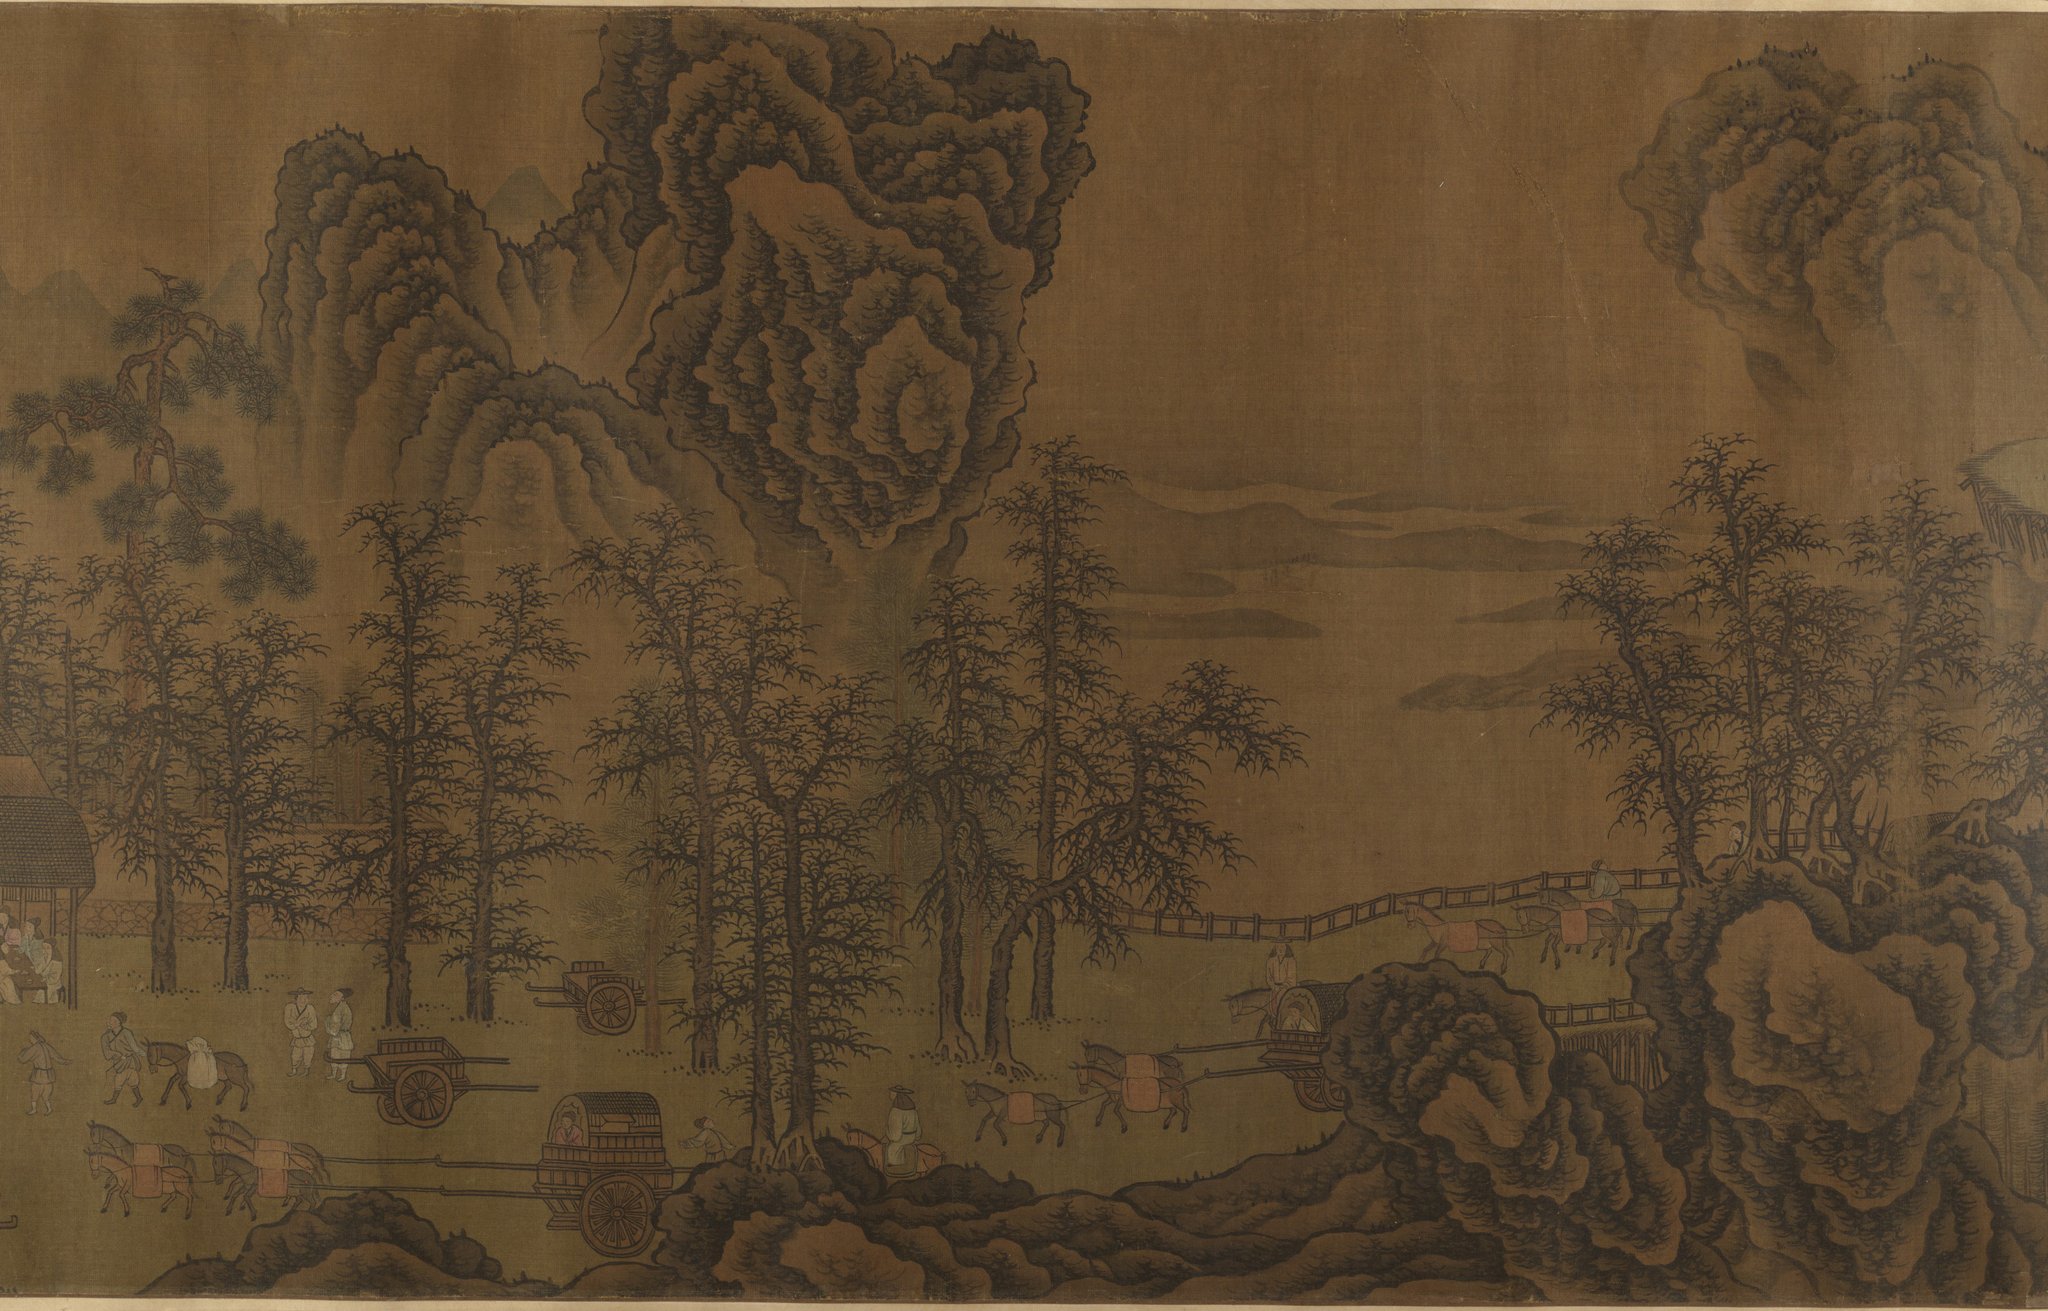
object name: handscroll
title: Mountain Scenery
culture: chinese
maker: unidentified artist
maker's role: artist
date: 1368-1911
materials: ink, silk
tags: mountains,landscapes